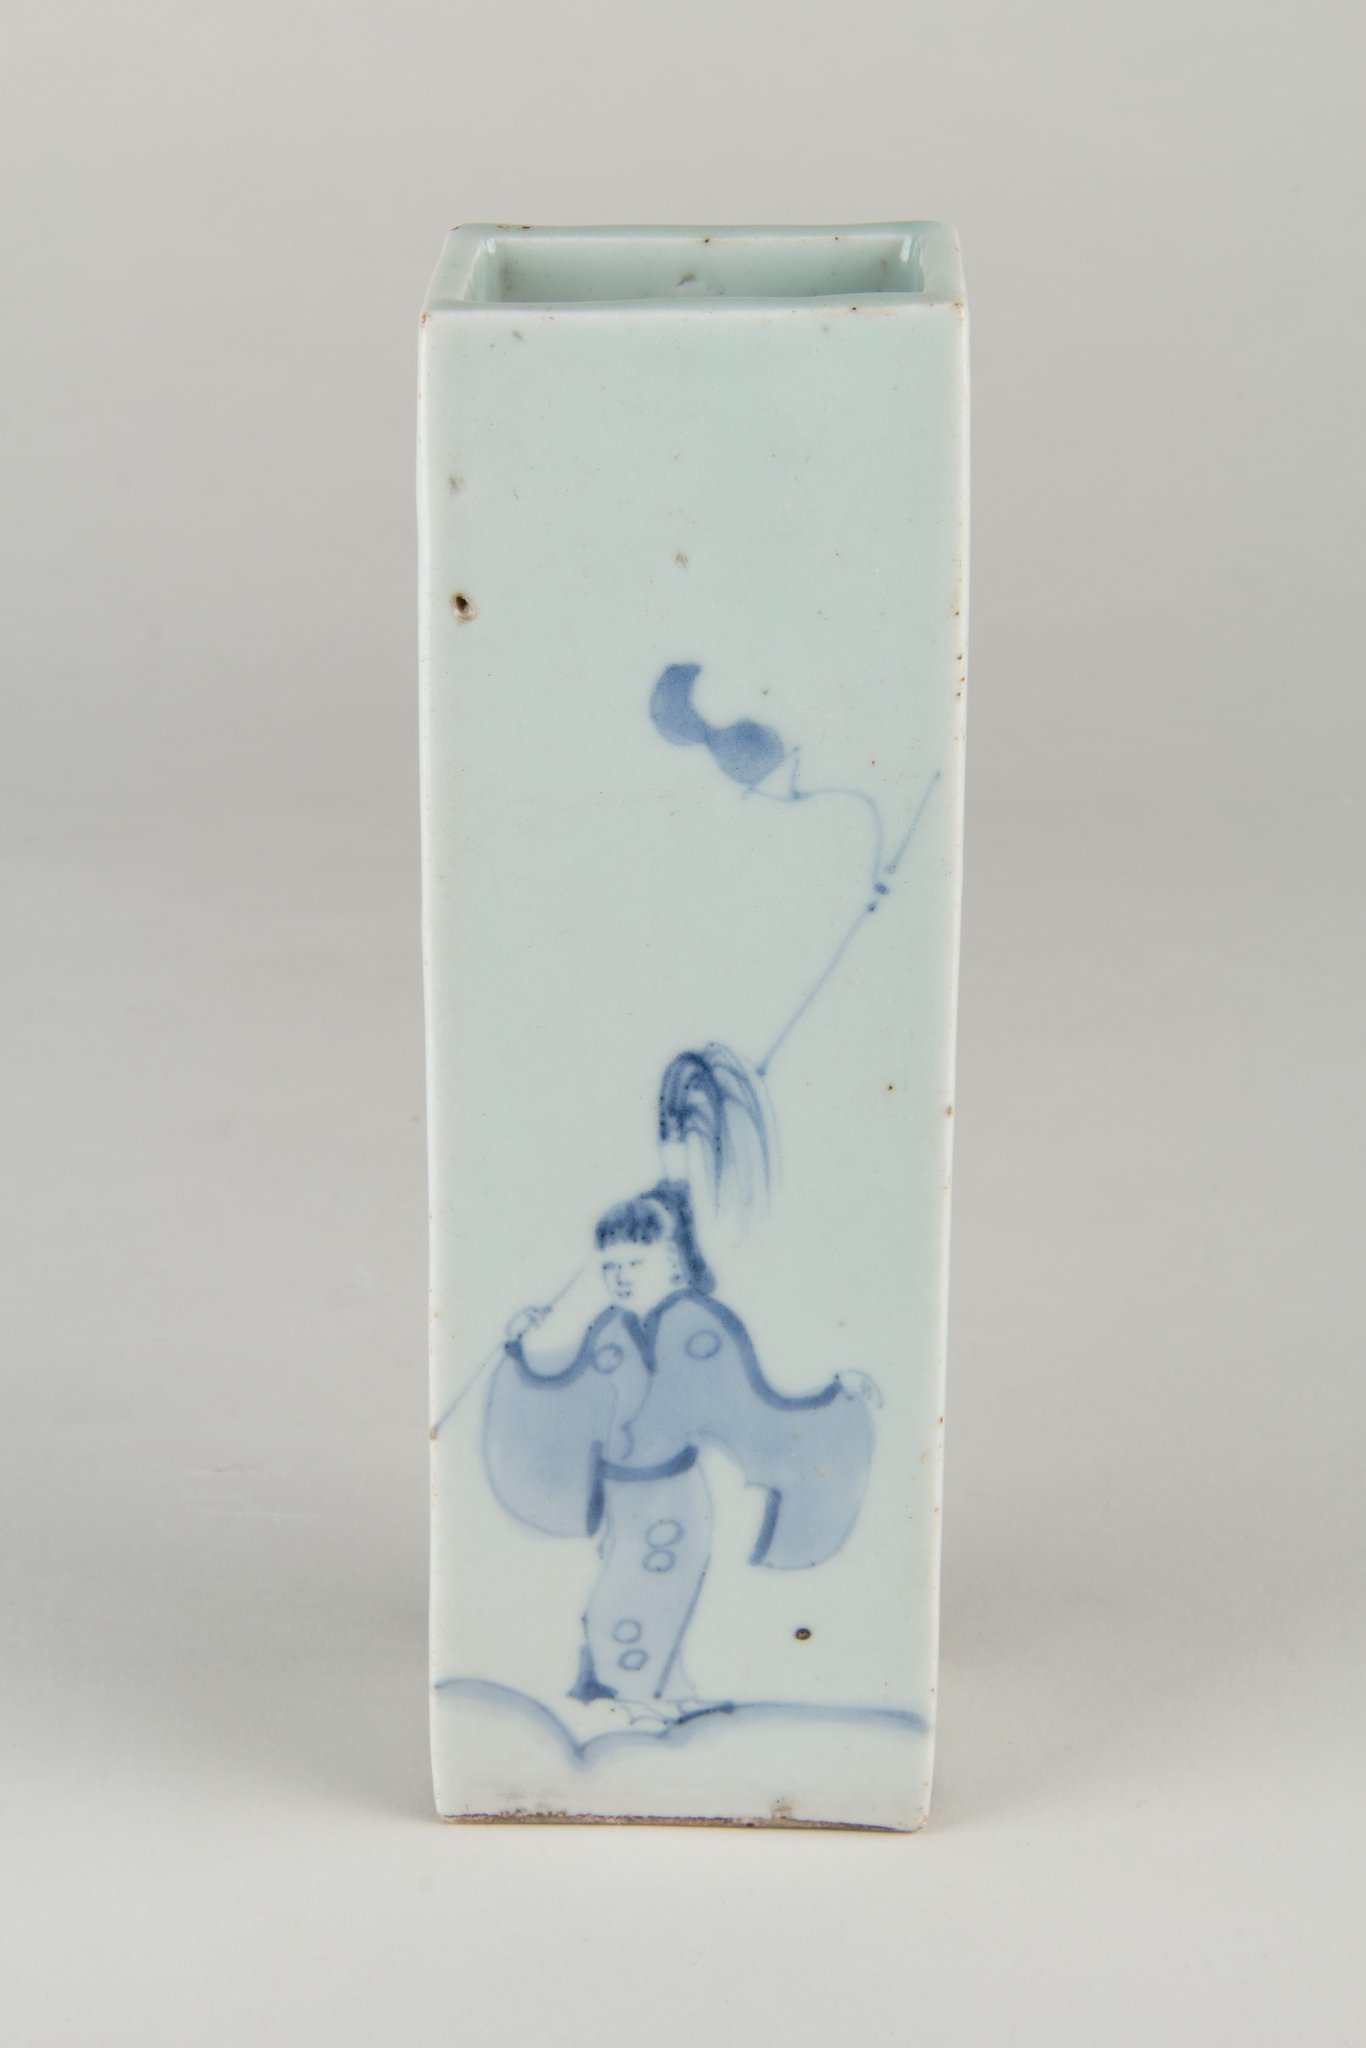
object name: hanging vase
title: Hanging Flower Vase with Figural Design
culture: japanese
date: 1634-1666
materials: porcelain, stoneware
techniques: underglaze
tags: women